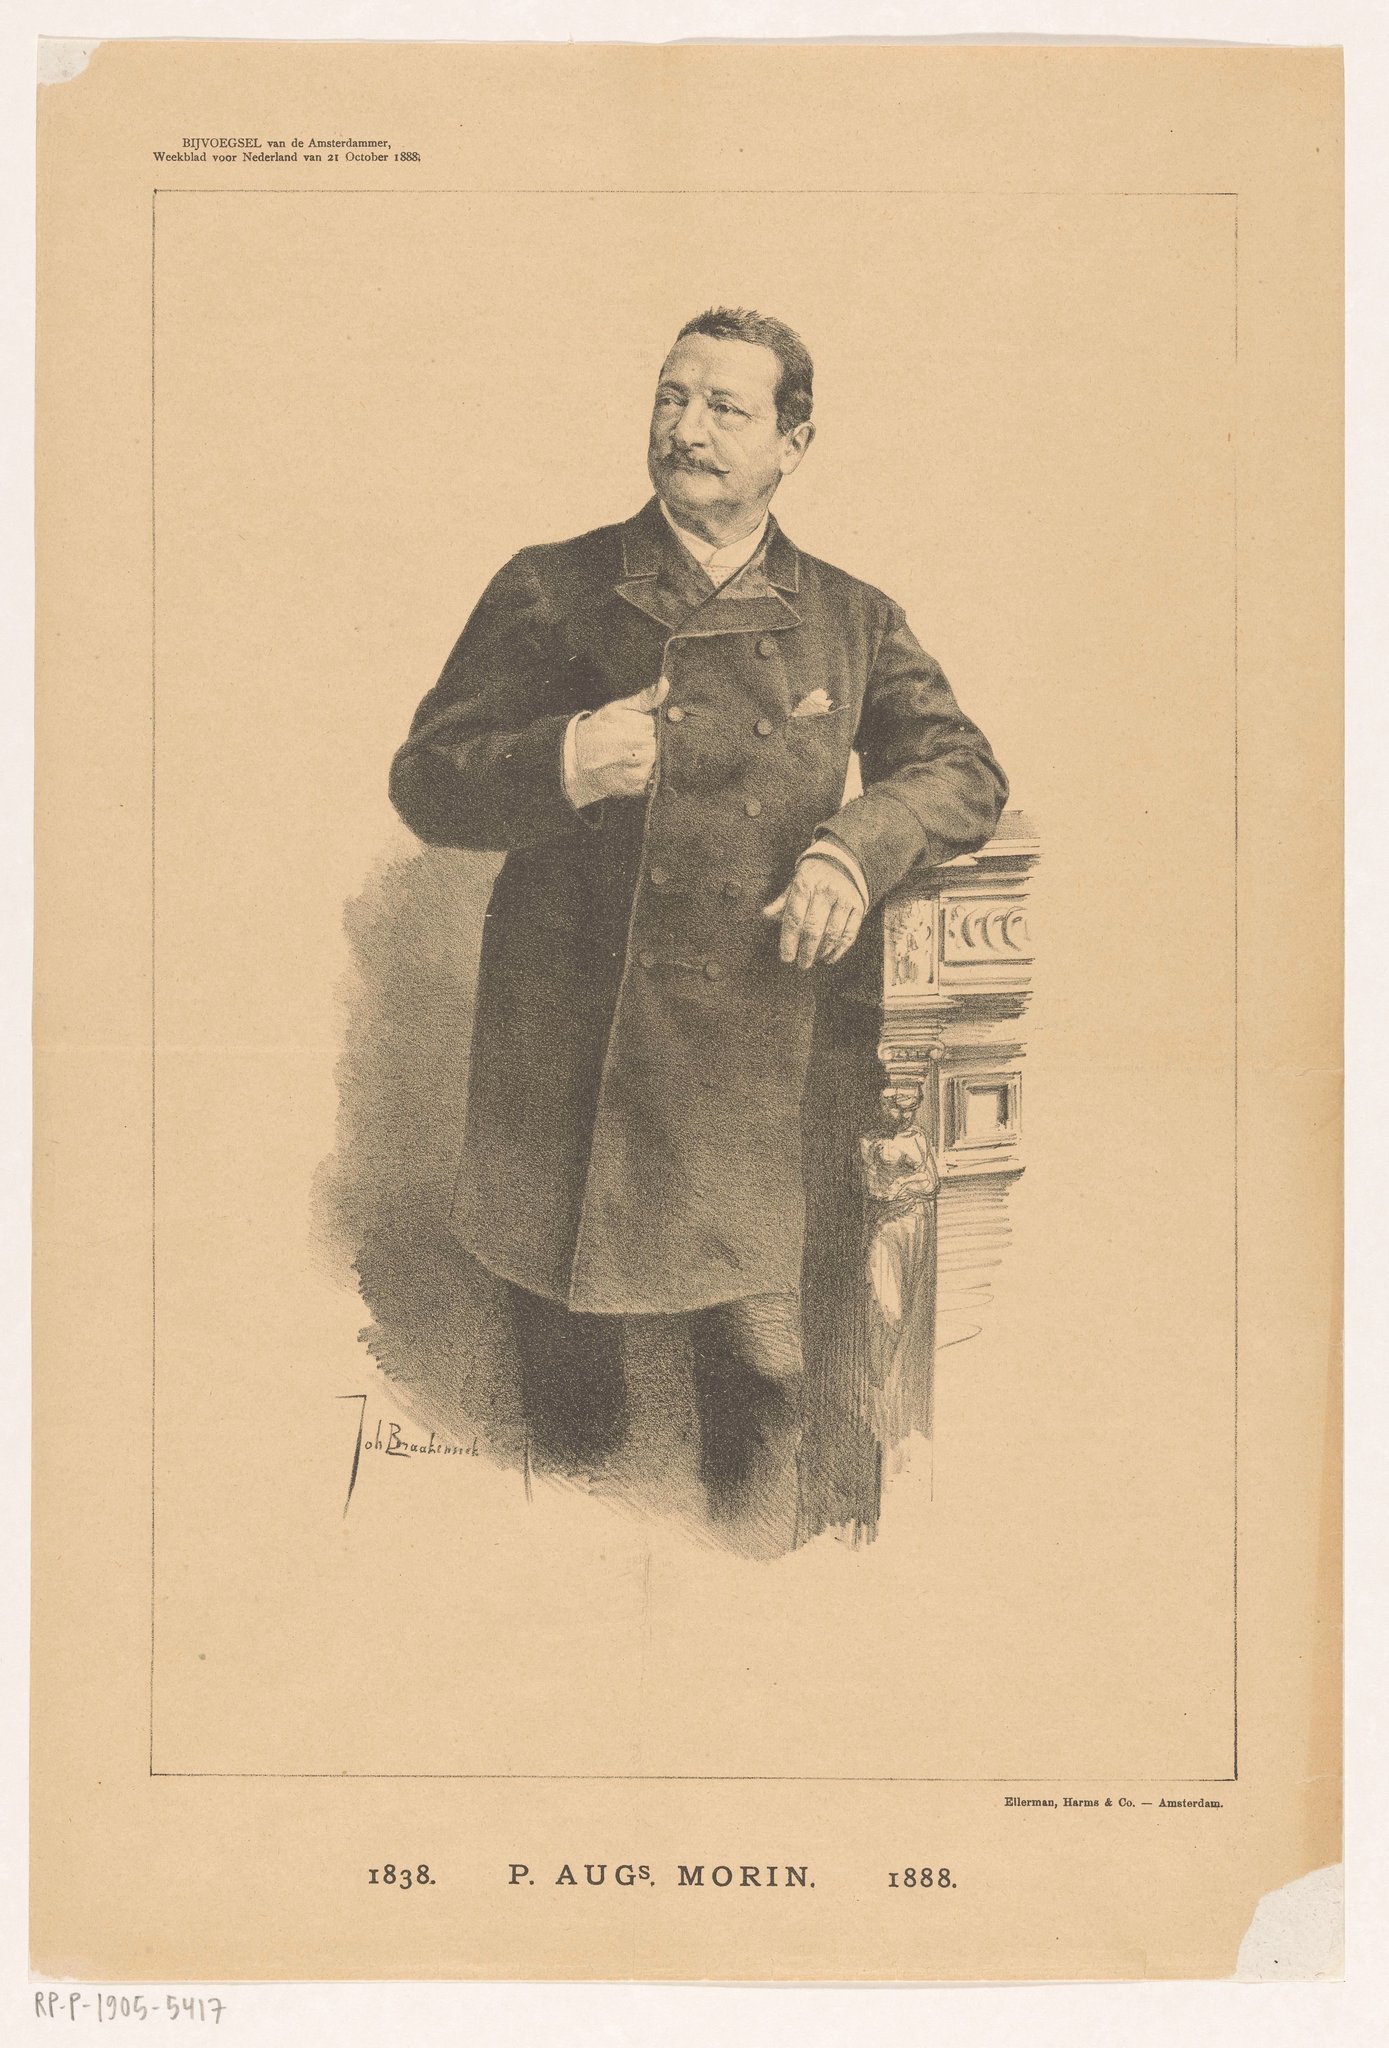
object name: print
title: P. Aug. Morin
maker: johan braakensiek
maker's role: draughtsman, print maker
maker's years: 1858-1940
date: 1888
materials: paper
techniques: lithograph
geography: amsterdam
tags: amsterdam, portrait of actor, actress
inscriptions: collector's mark: Lugt 2228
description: Verschenen in het bijvoegsel van 'De Amsterdammer, Weekblad voor Nederland' van 21 oktober 1888.